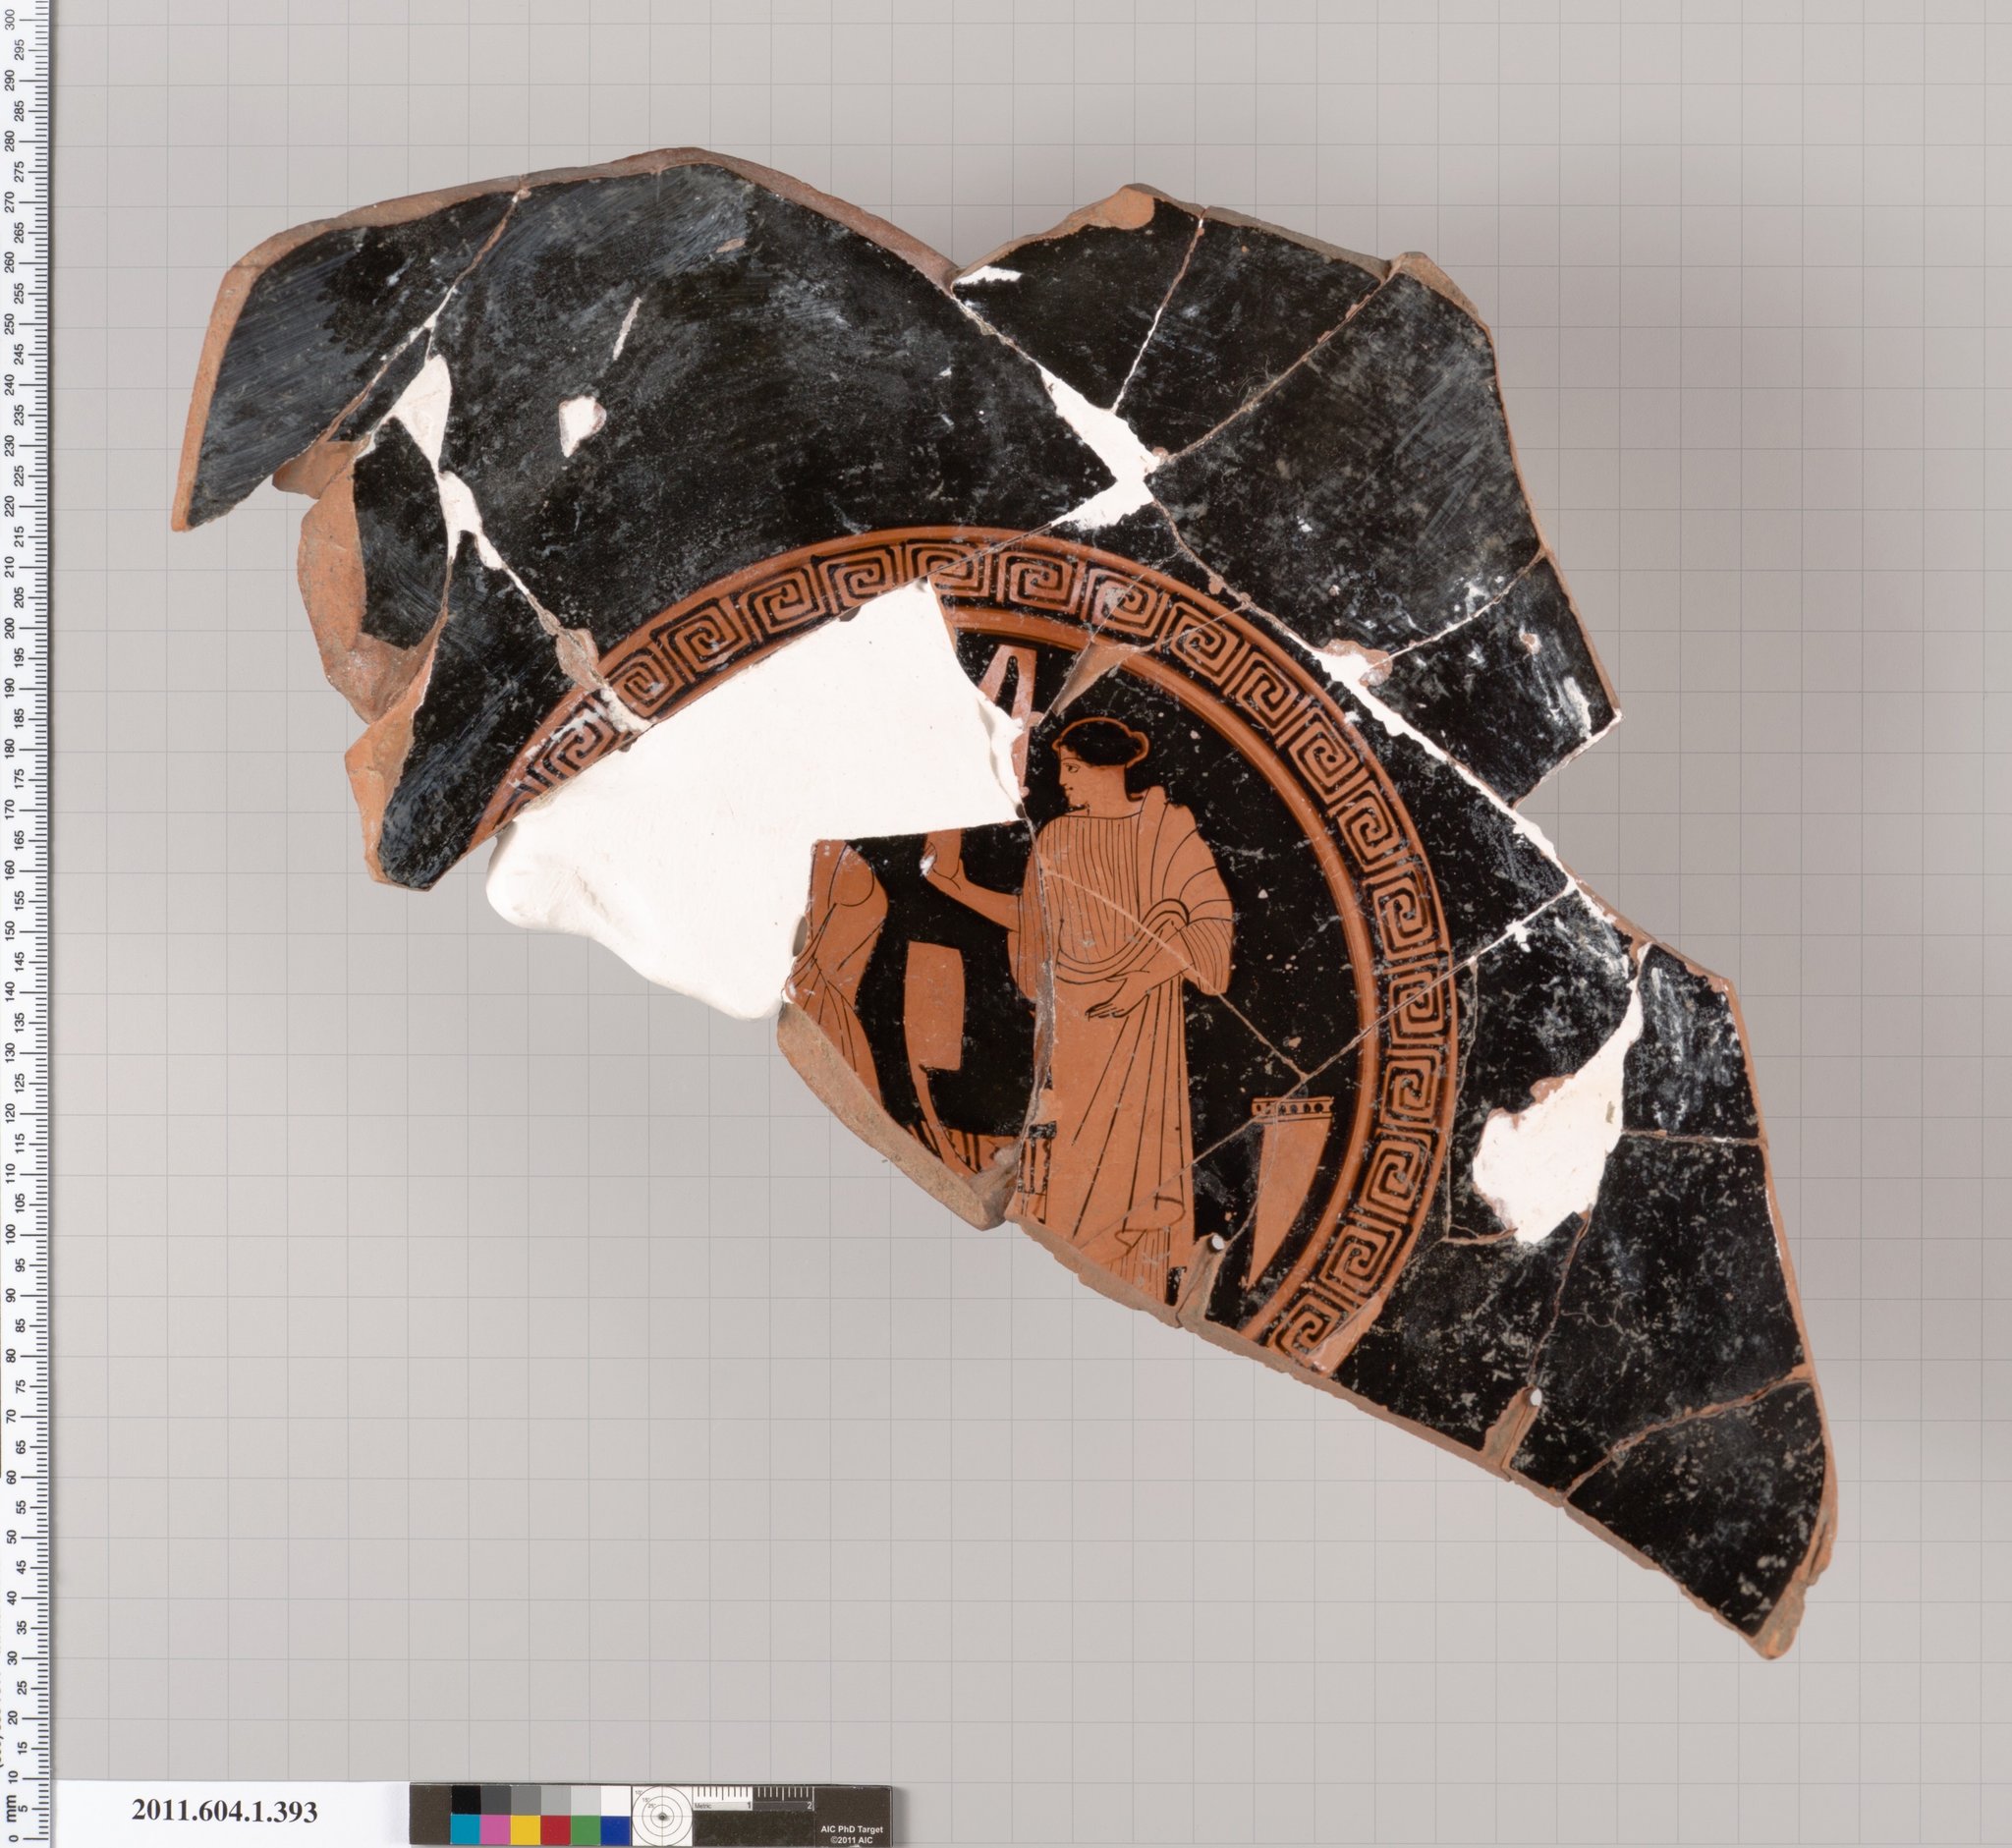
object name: kylix fragment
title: Terracotta fragment of a kylix (drinking cup)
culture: greek, attic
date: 475-451 BCE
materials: terracotta